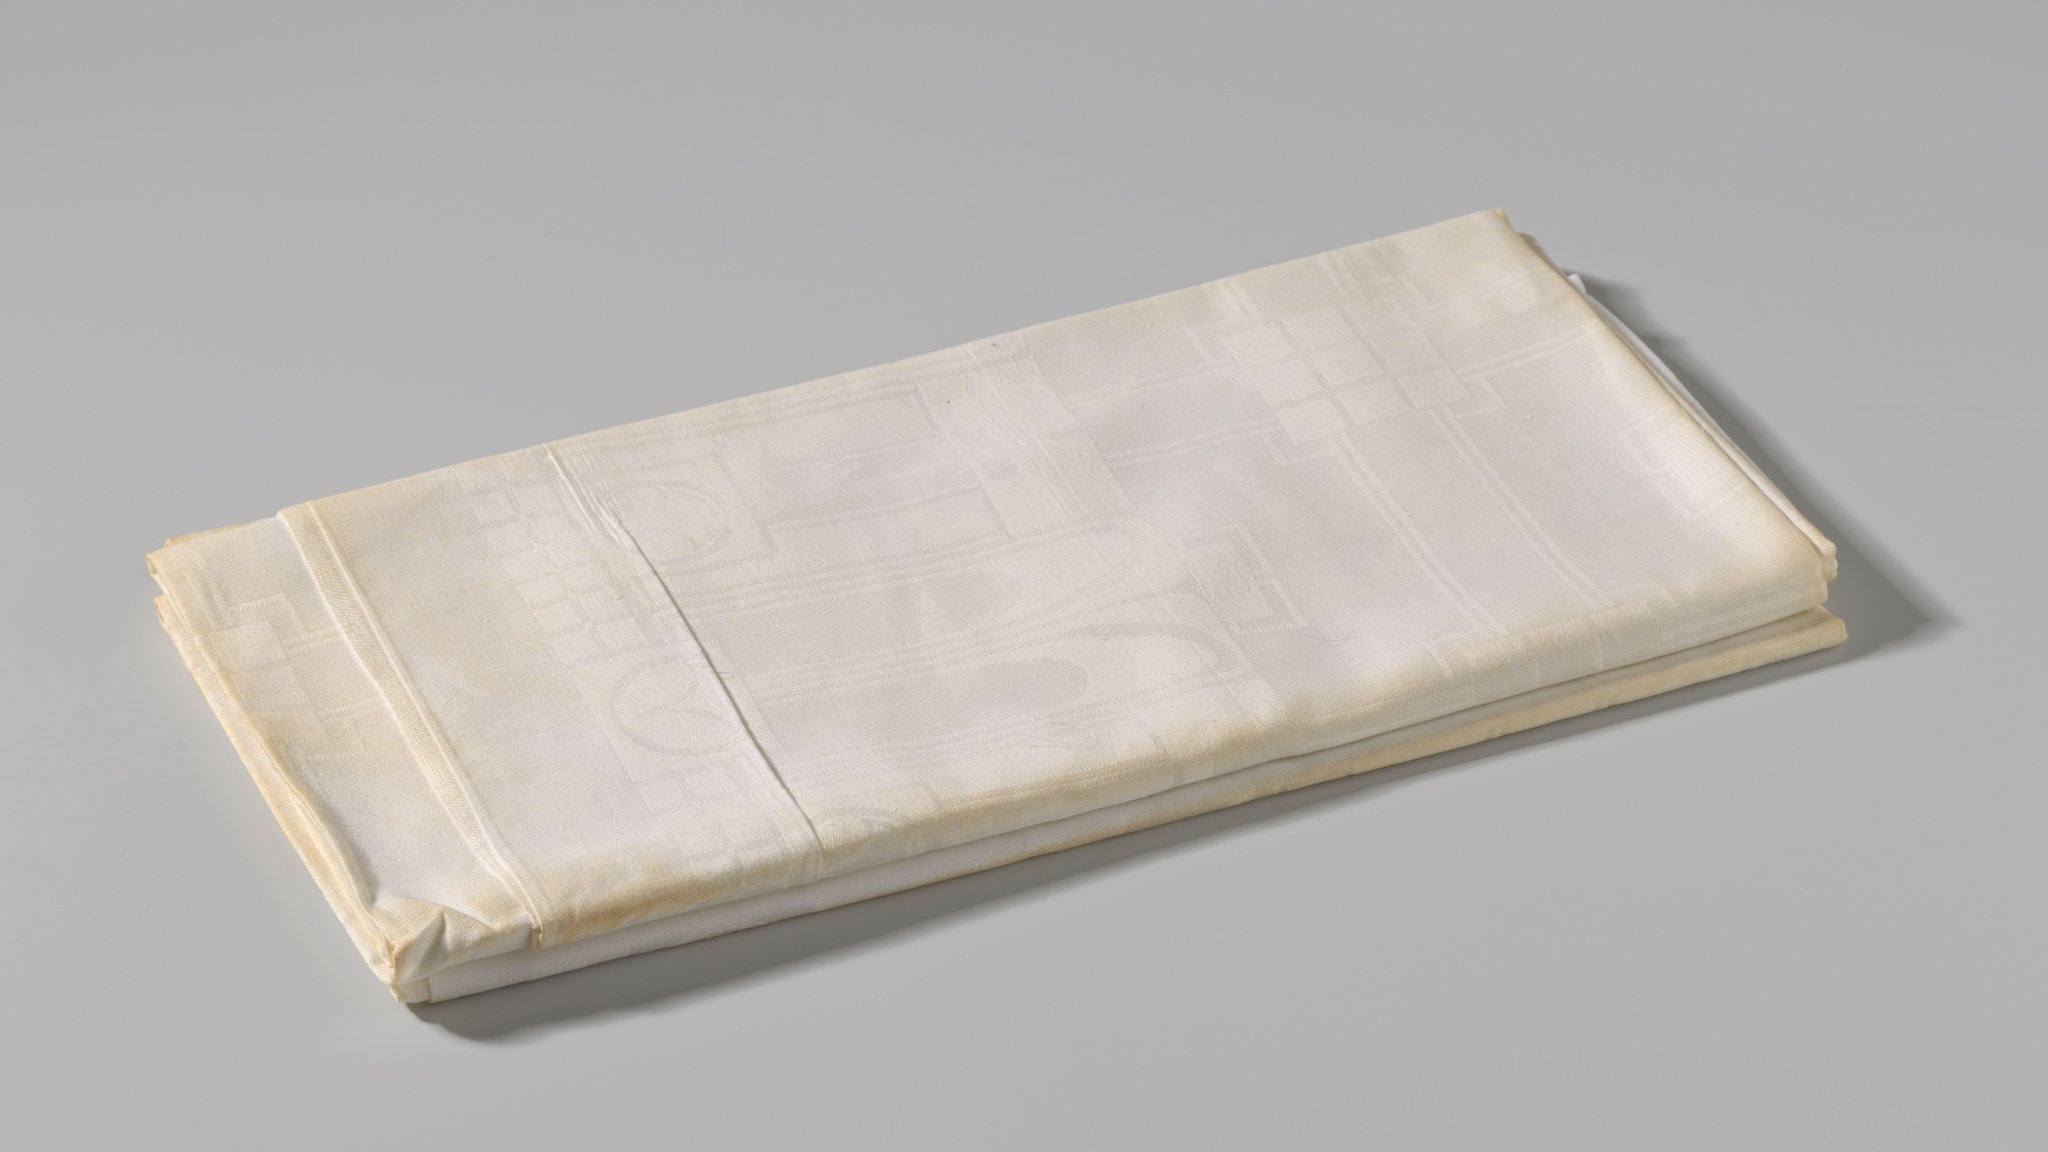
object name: tablecloth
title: Tafellaken van katoenen damast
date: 1900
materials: cotton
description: Tafellaken van katoenen damast, met godronrand, Jugendstil. Bij het tafellaken horen vier bijpassende servetten.